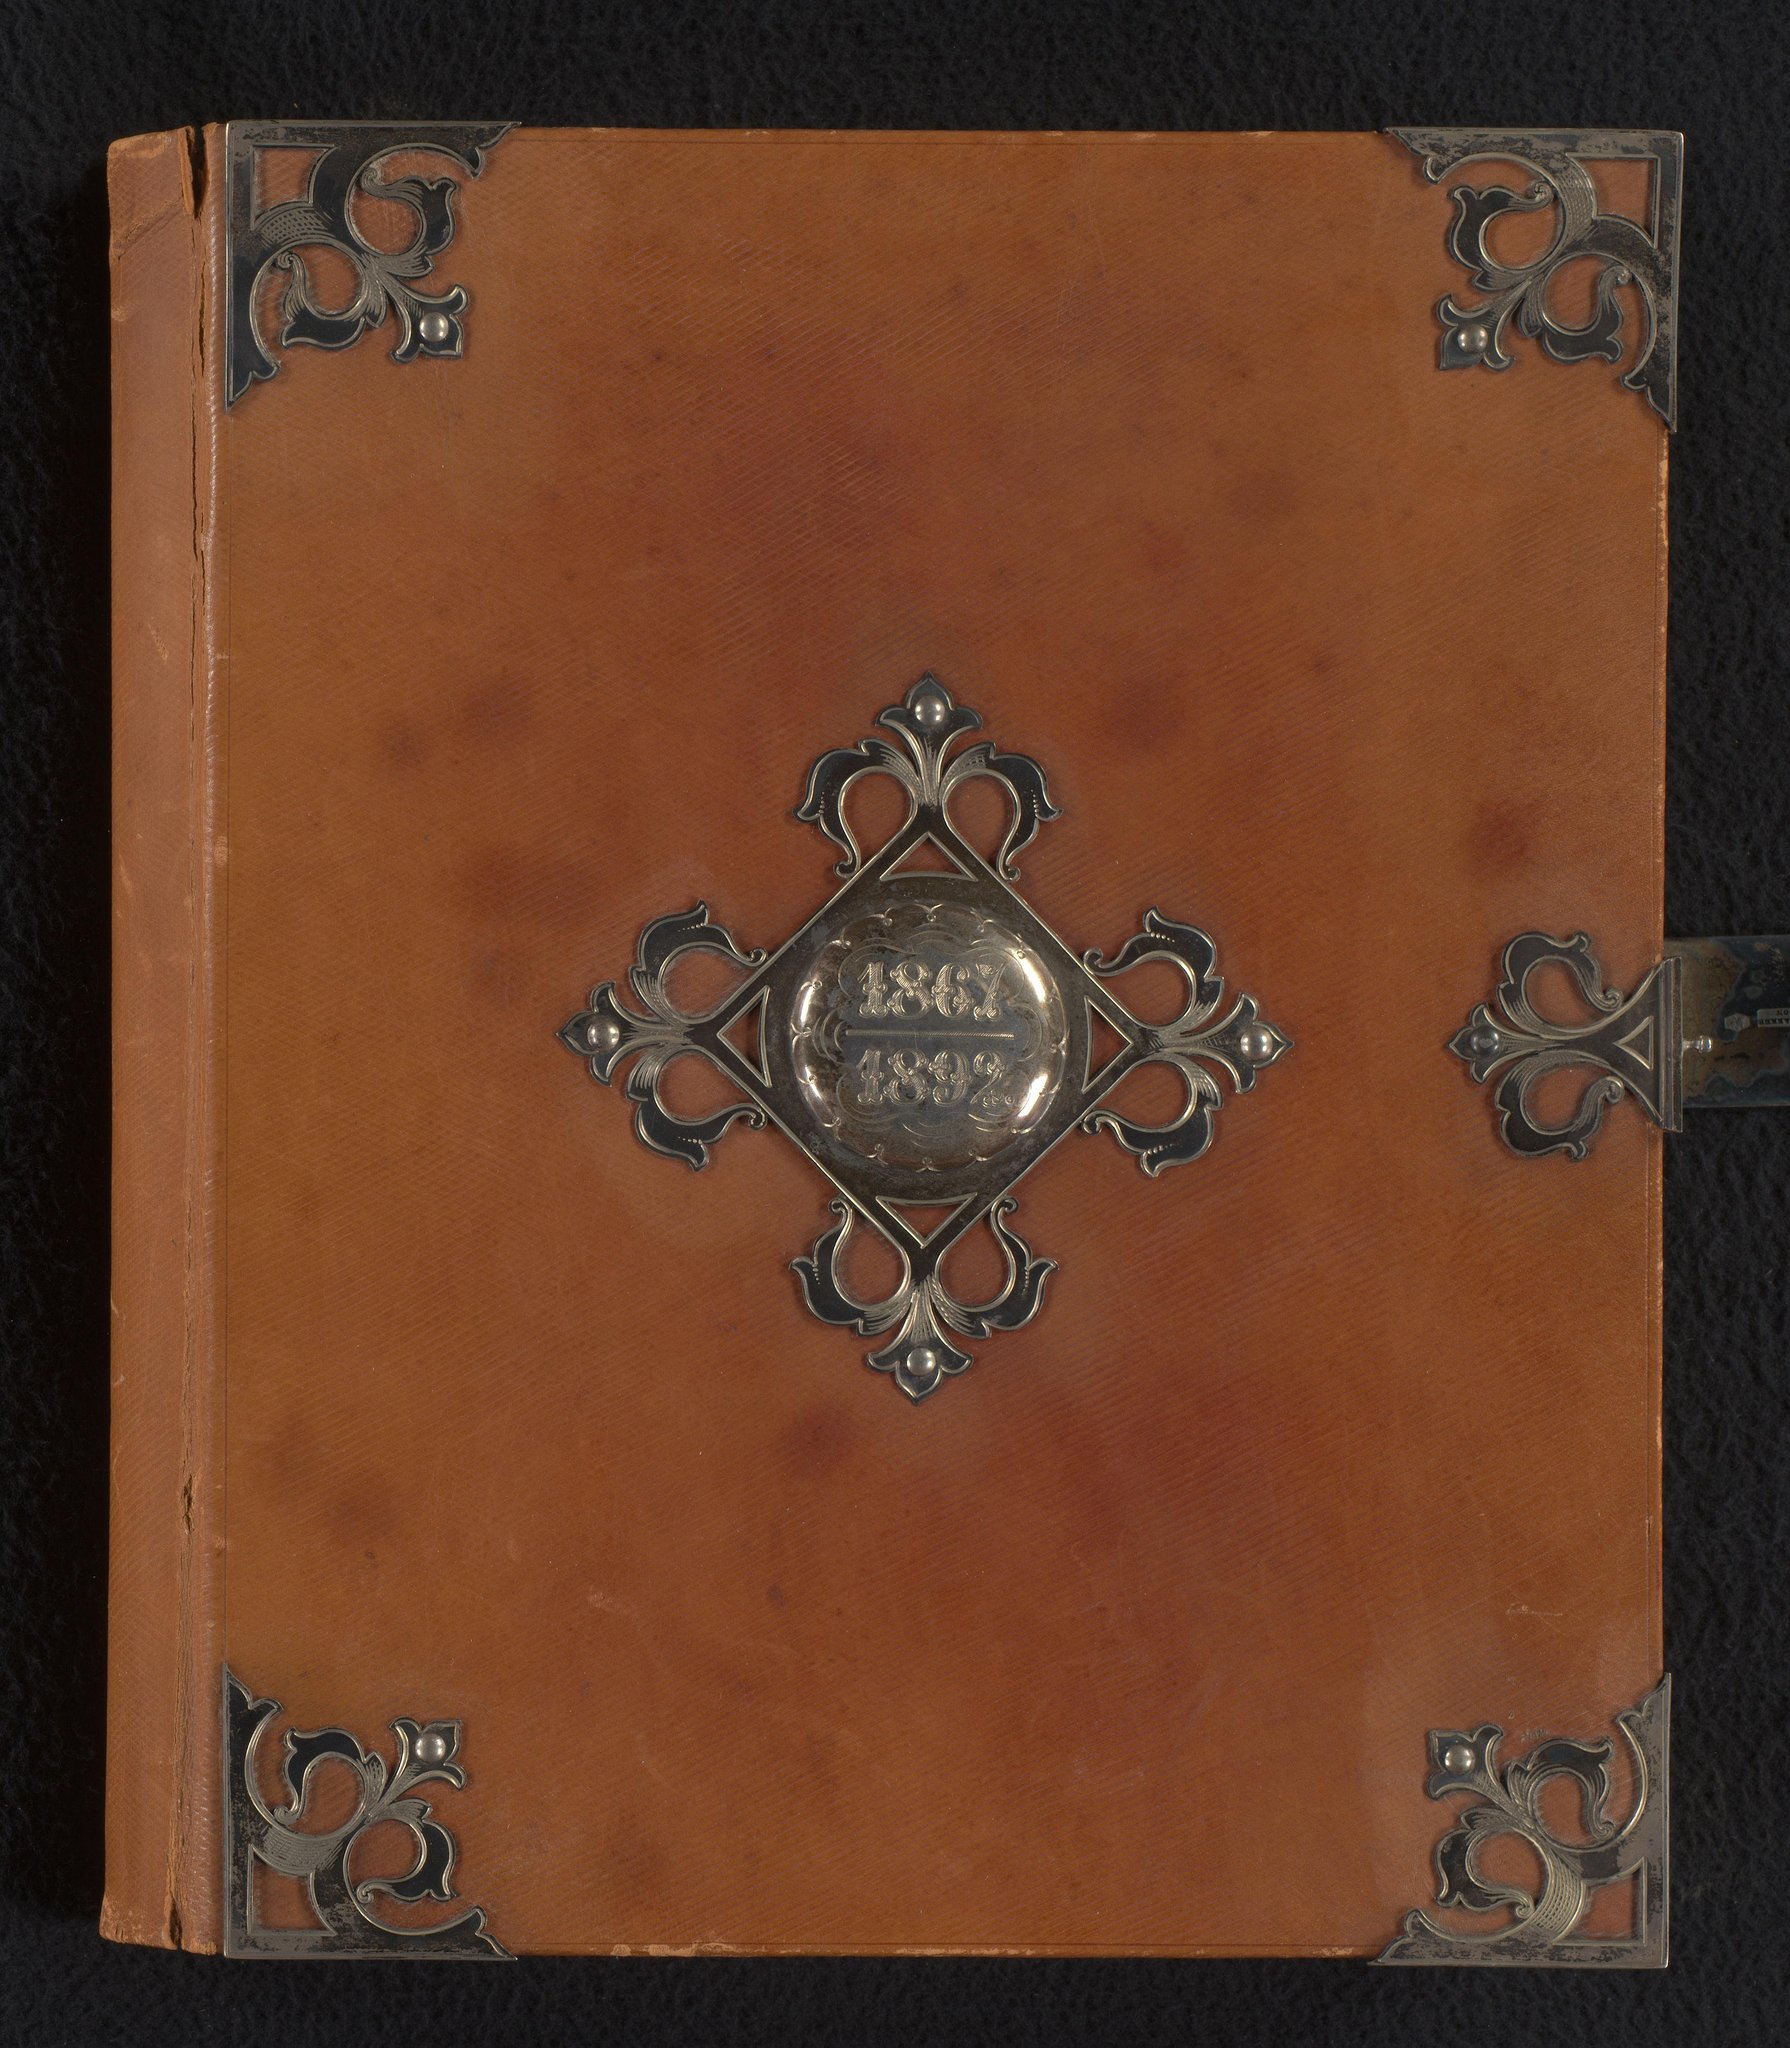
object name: slip in album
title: Jubileumalbum '1867 - 1892' voor de directeuren van de Binnenlandsche Vaart Risico Sociëteit met 30 carte-de-visite-portretten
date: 1892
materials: paper, cardboard, leather, silver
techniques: albumen print, calligraphy, marbling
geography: netherlands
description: Jubileumalbum '1867 - 1892', met in sierschrift op gemaakte titelpagina: 'Aandenken aangeboden door de Agenten van de Binnenlandsche Vaart Risico Sociëteit aan heeren Directeuren bij gelegenheid van hun 25 Jarig Jubileum, 18 februari 1892'. In het album zit een losse kabinetfoto en een handgeschreven 'Lijst der Agenten', met 30 carte-de-visite-portretten en 26 gedrukte visitekaartjes. De agenten zijn afkomstig uit het hele land: van Texel tot Hoogeveen; van Oud-Beijerland tot Bolsward etc. De foto's bevatten handgeschreven bijschriften. Een kabinetfoto zit los voorin het album.